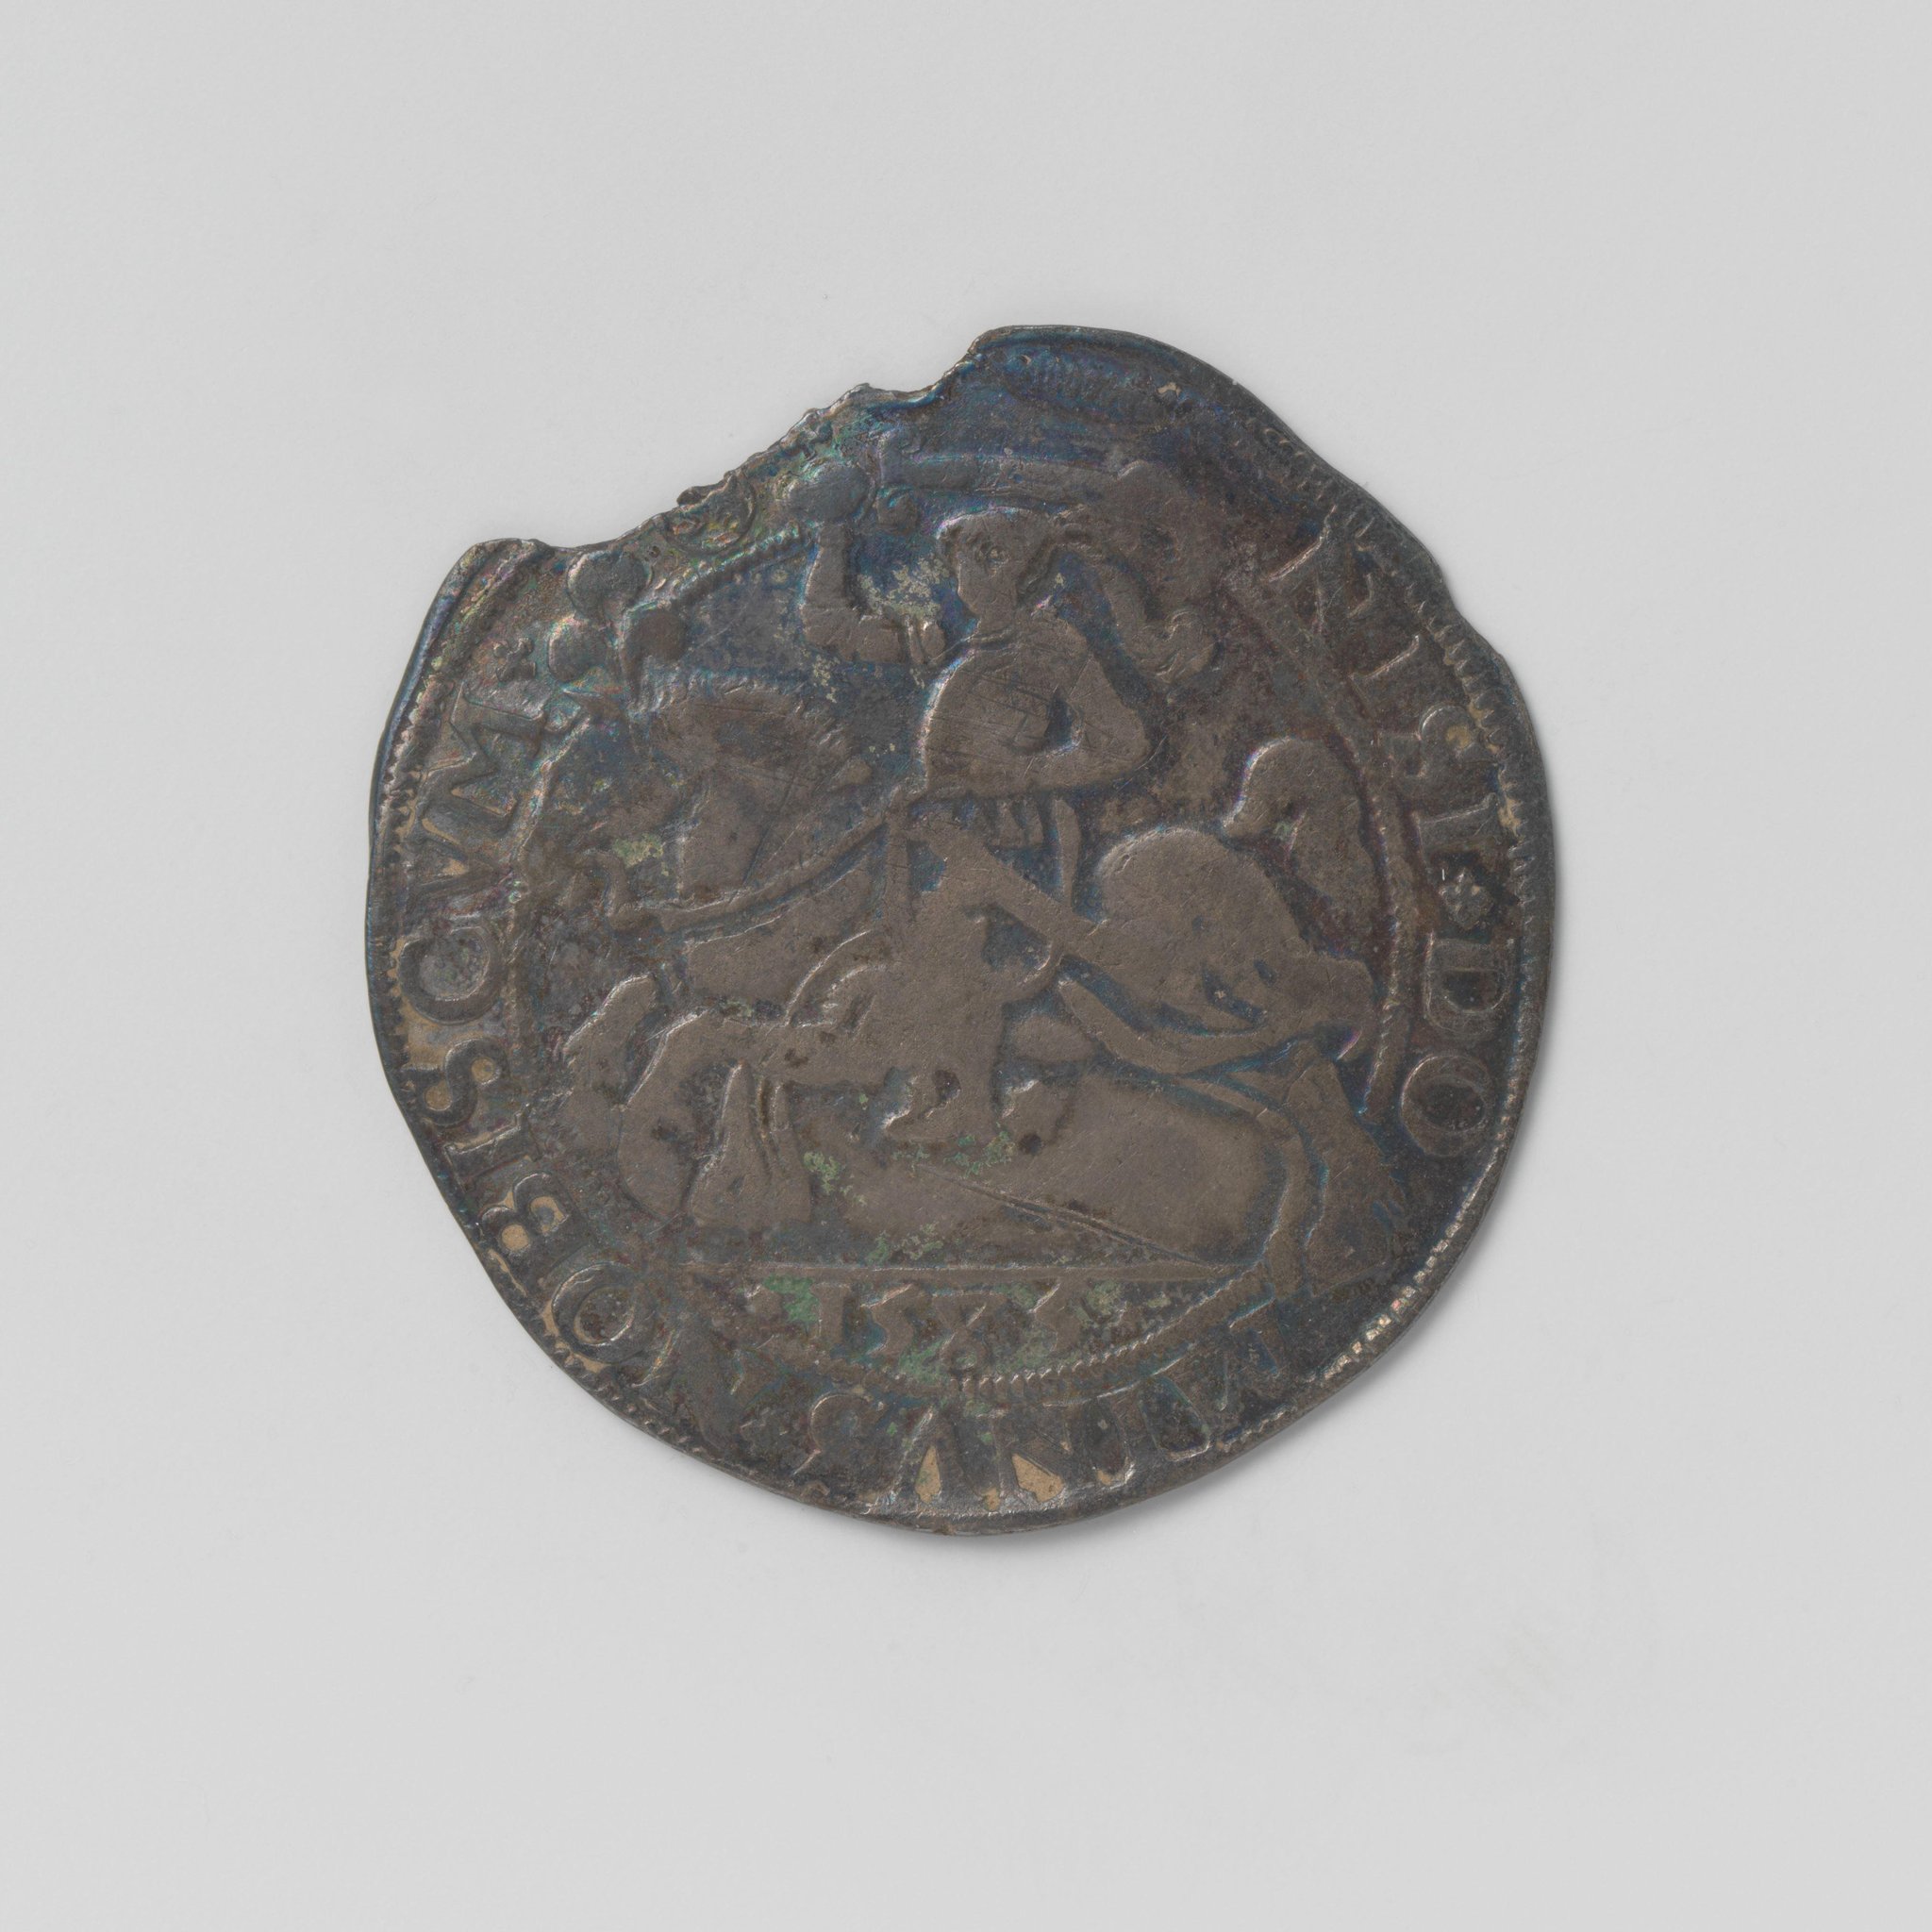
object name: coin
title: Snaphaanschelling van Friesland, 1585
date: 1585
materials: silver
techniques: striking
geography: leeuwarden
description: Zilveren munt. Voorzijde: ridder te paard naar links. In rechterhand zwaard. In afsnede jaartal Keerzijde: op lang gebloemd kruis ongekroond wapenschild van Friesland. Muntplaatje uitgebroken.